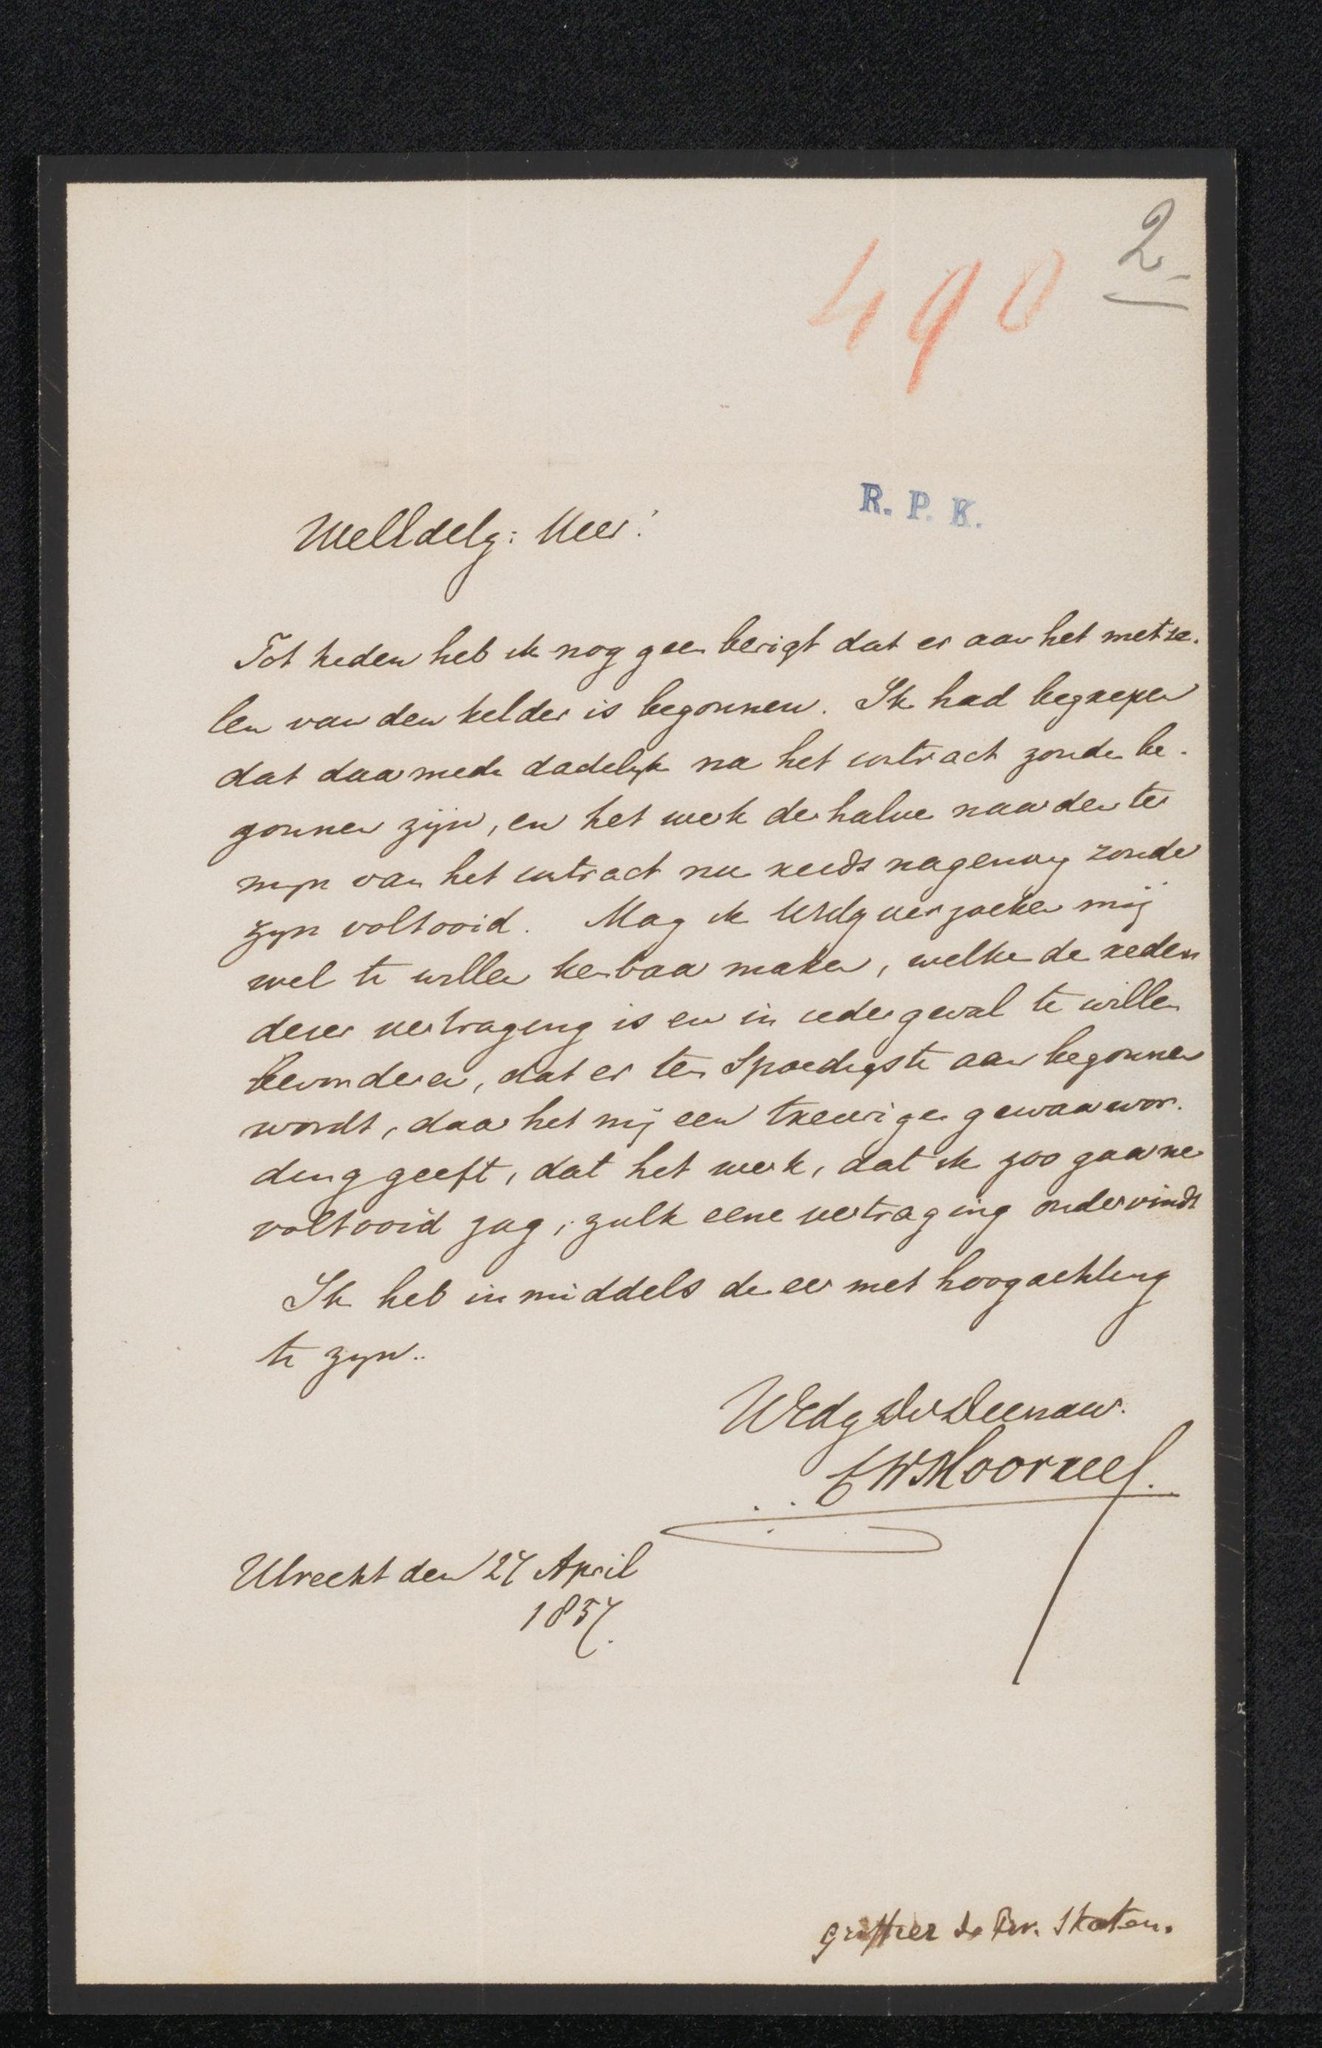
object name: letter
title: Brief aan Christiaan Kramm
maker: christiaan wilhelmus moorrees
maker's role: draughtsman, print maker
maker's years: 1801-1867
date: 1857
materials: ink, paper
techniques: pen, writing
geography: utrecht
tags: utrecht, print maker, draughtsman, christiaan kramm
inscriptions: collector's mark: Lugt 2233